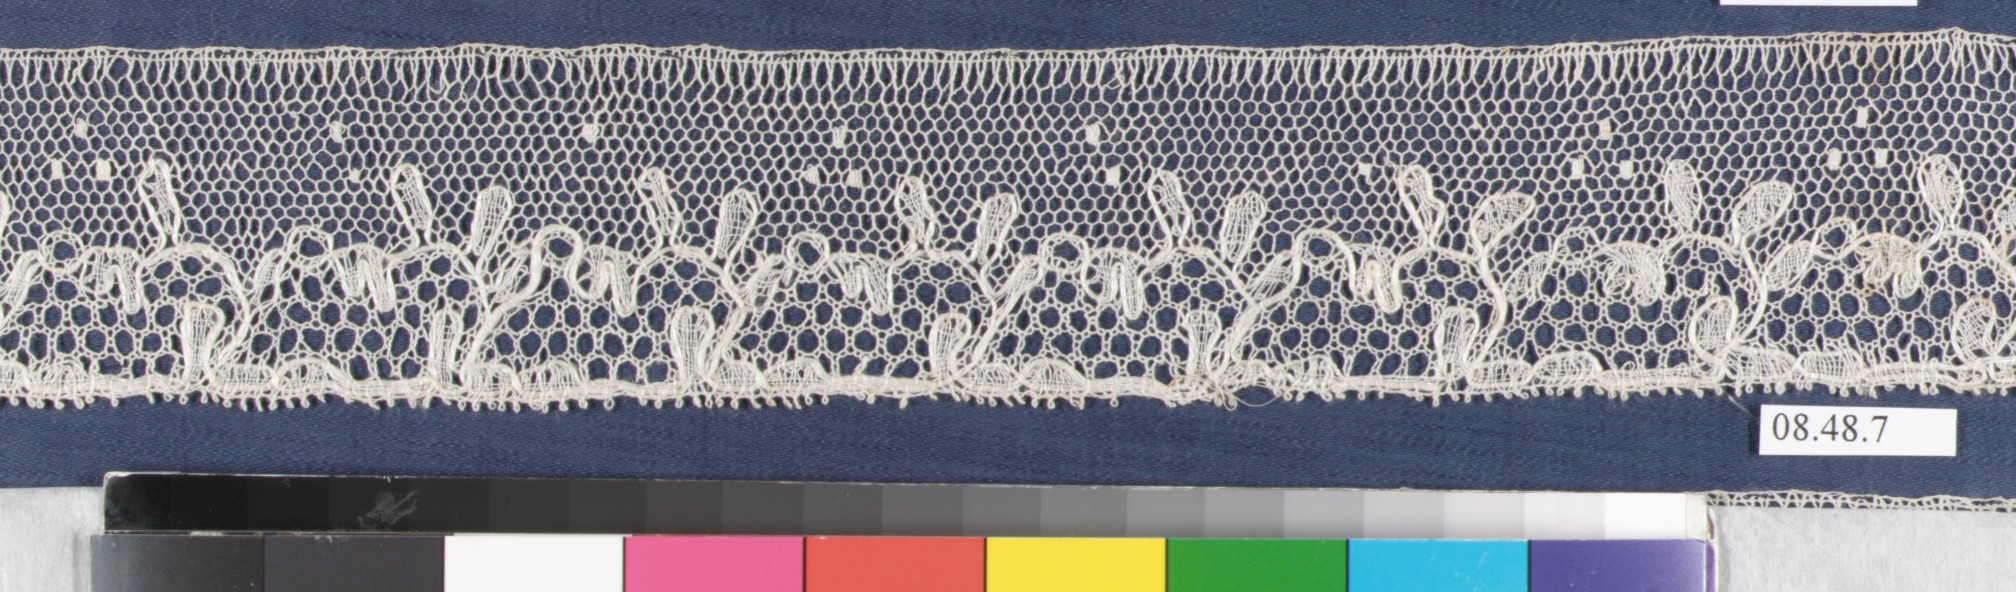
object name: edging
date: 1801-1900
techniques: lace